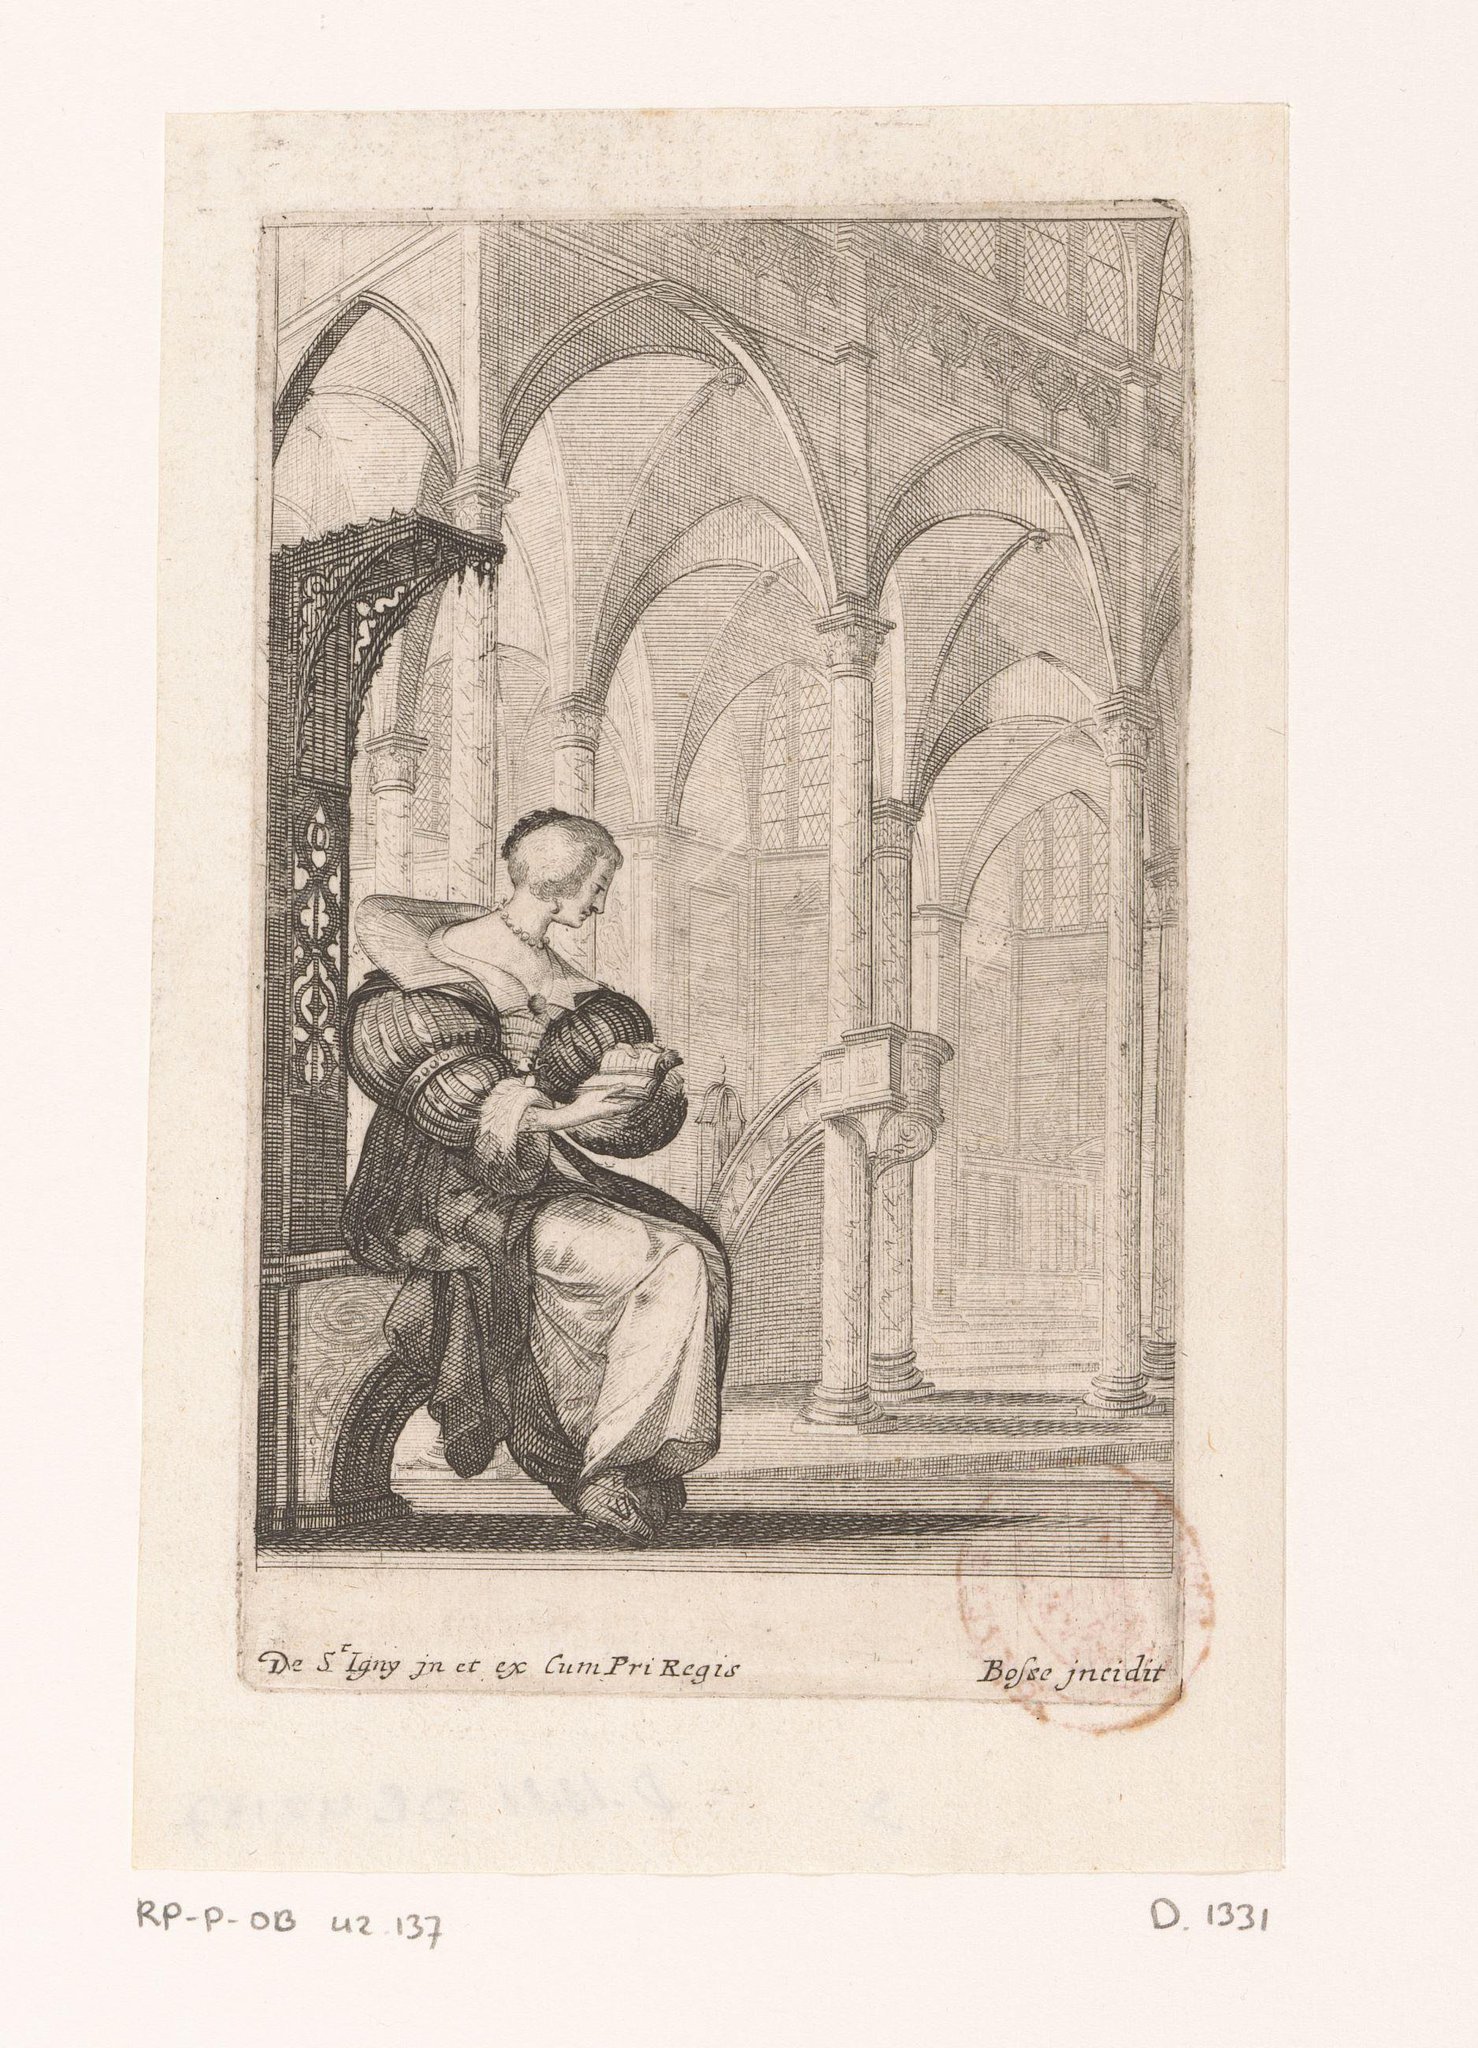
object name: costume print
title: La Noblesse Française à l’église (The French Nobility at Church)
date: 1628-1629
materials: paper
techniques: engraving, etching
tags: ear-rings (+ women's clothes), reading, dress, gown (vlieger) (+ women's clothes), styles of hairdress - aa - ~ women, neck-gear: collar (+ women's clothes), shoes, sandals (+ women's clothes), skirt (+ women's clothes), sleeves: cuffs (+ women's clothes), dress, gown (+ women's clothes), interior of church, sleeves (+ women's clothes), necklace (+ women's clothes), one person praying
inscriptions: collector's mark: Lugt 240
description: Bosse portrayed the Gothic churches of Paris as sites of piety and fashionability. While praying or merely strutting through the centuries-old architecture, the churchgoers in these prints sport the latest styles. For example, in the few years since Callot’s series (adjacent), an ornate and expensive form of lace cutwork – reticella – had become a popular form of decoration for collars and cuffs.